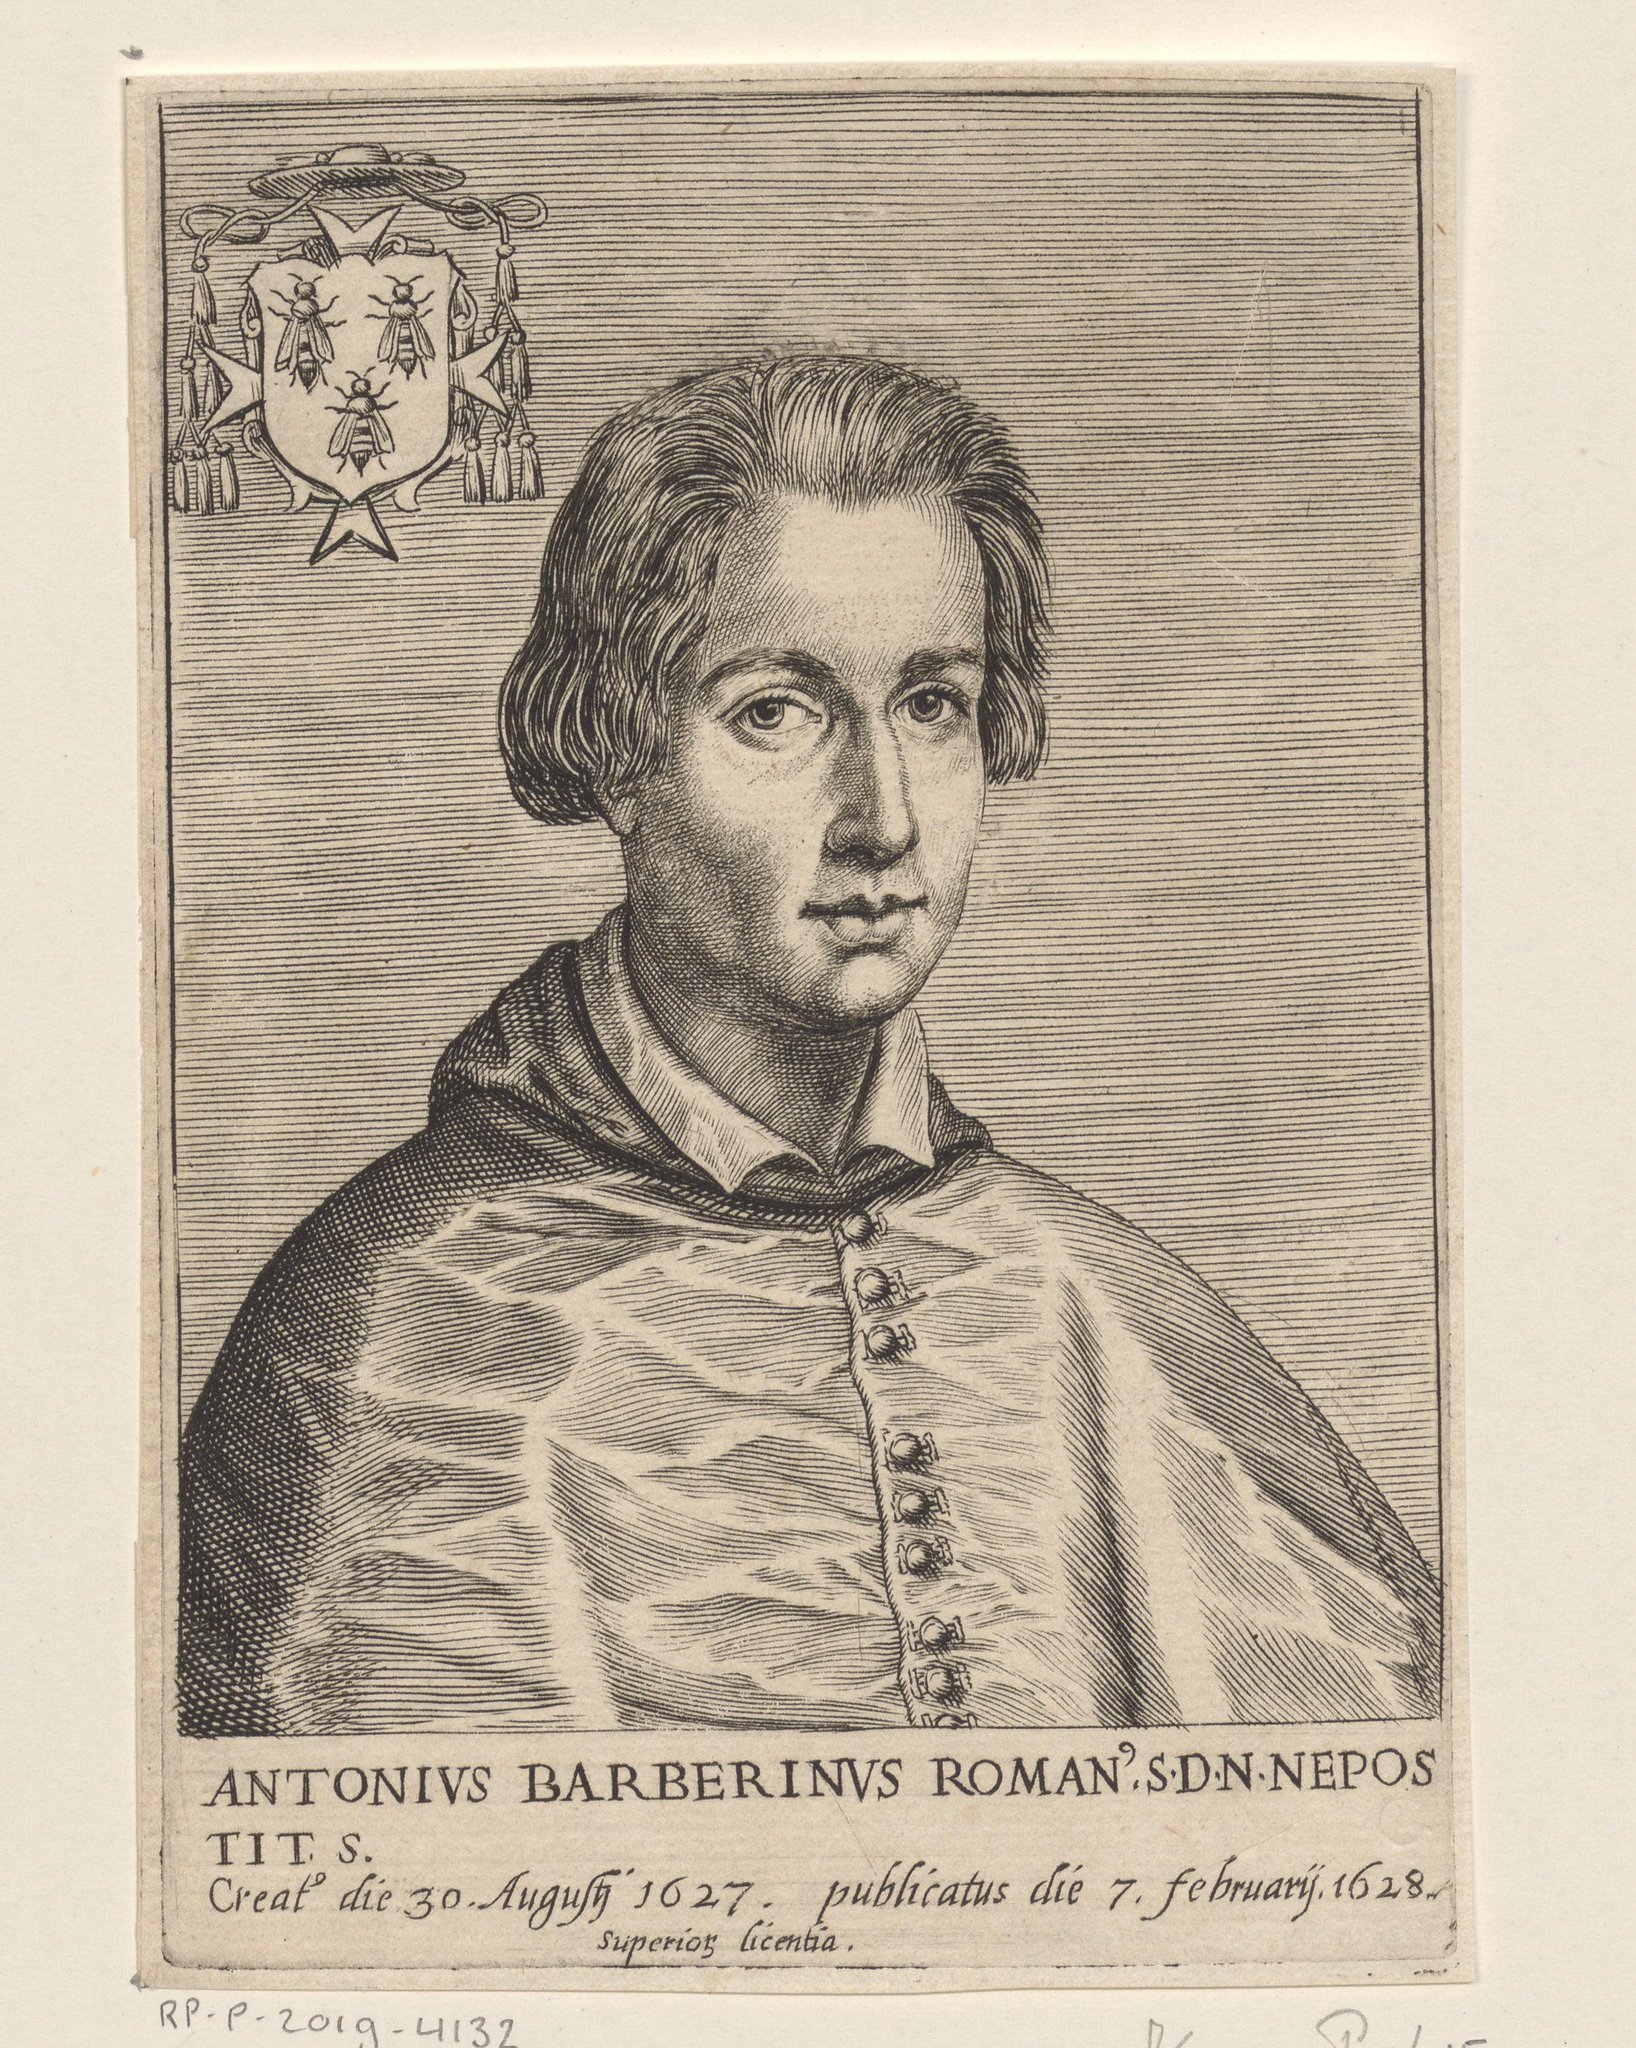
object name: print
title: Portret van kardinaal Antonio Barberini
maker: Anonymous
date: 1628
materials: paper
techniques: engraving, etching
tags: rome, clergyman, antonio barberini (ii), historical persons, armorial bearing, heraldry